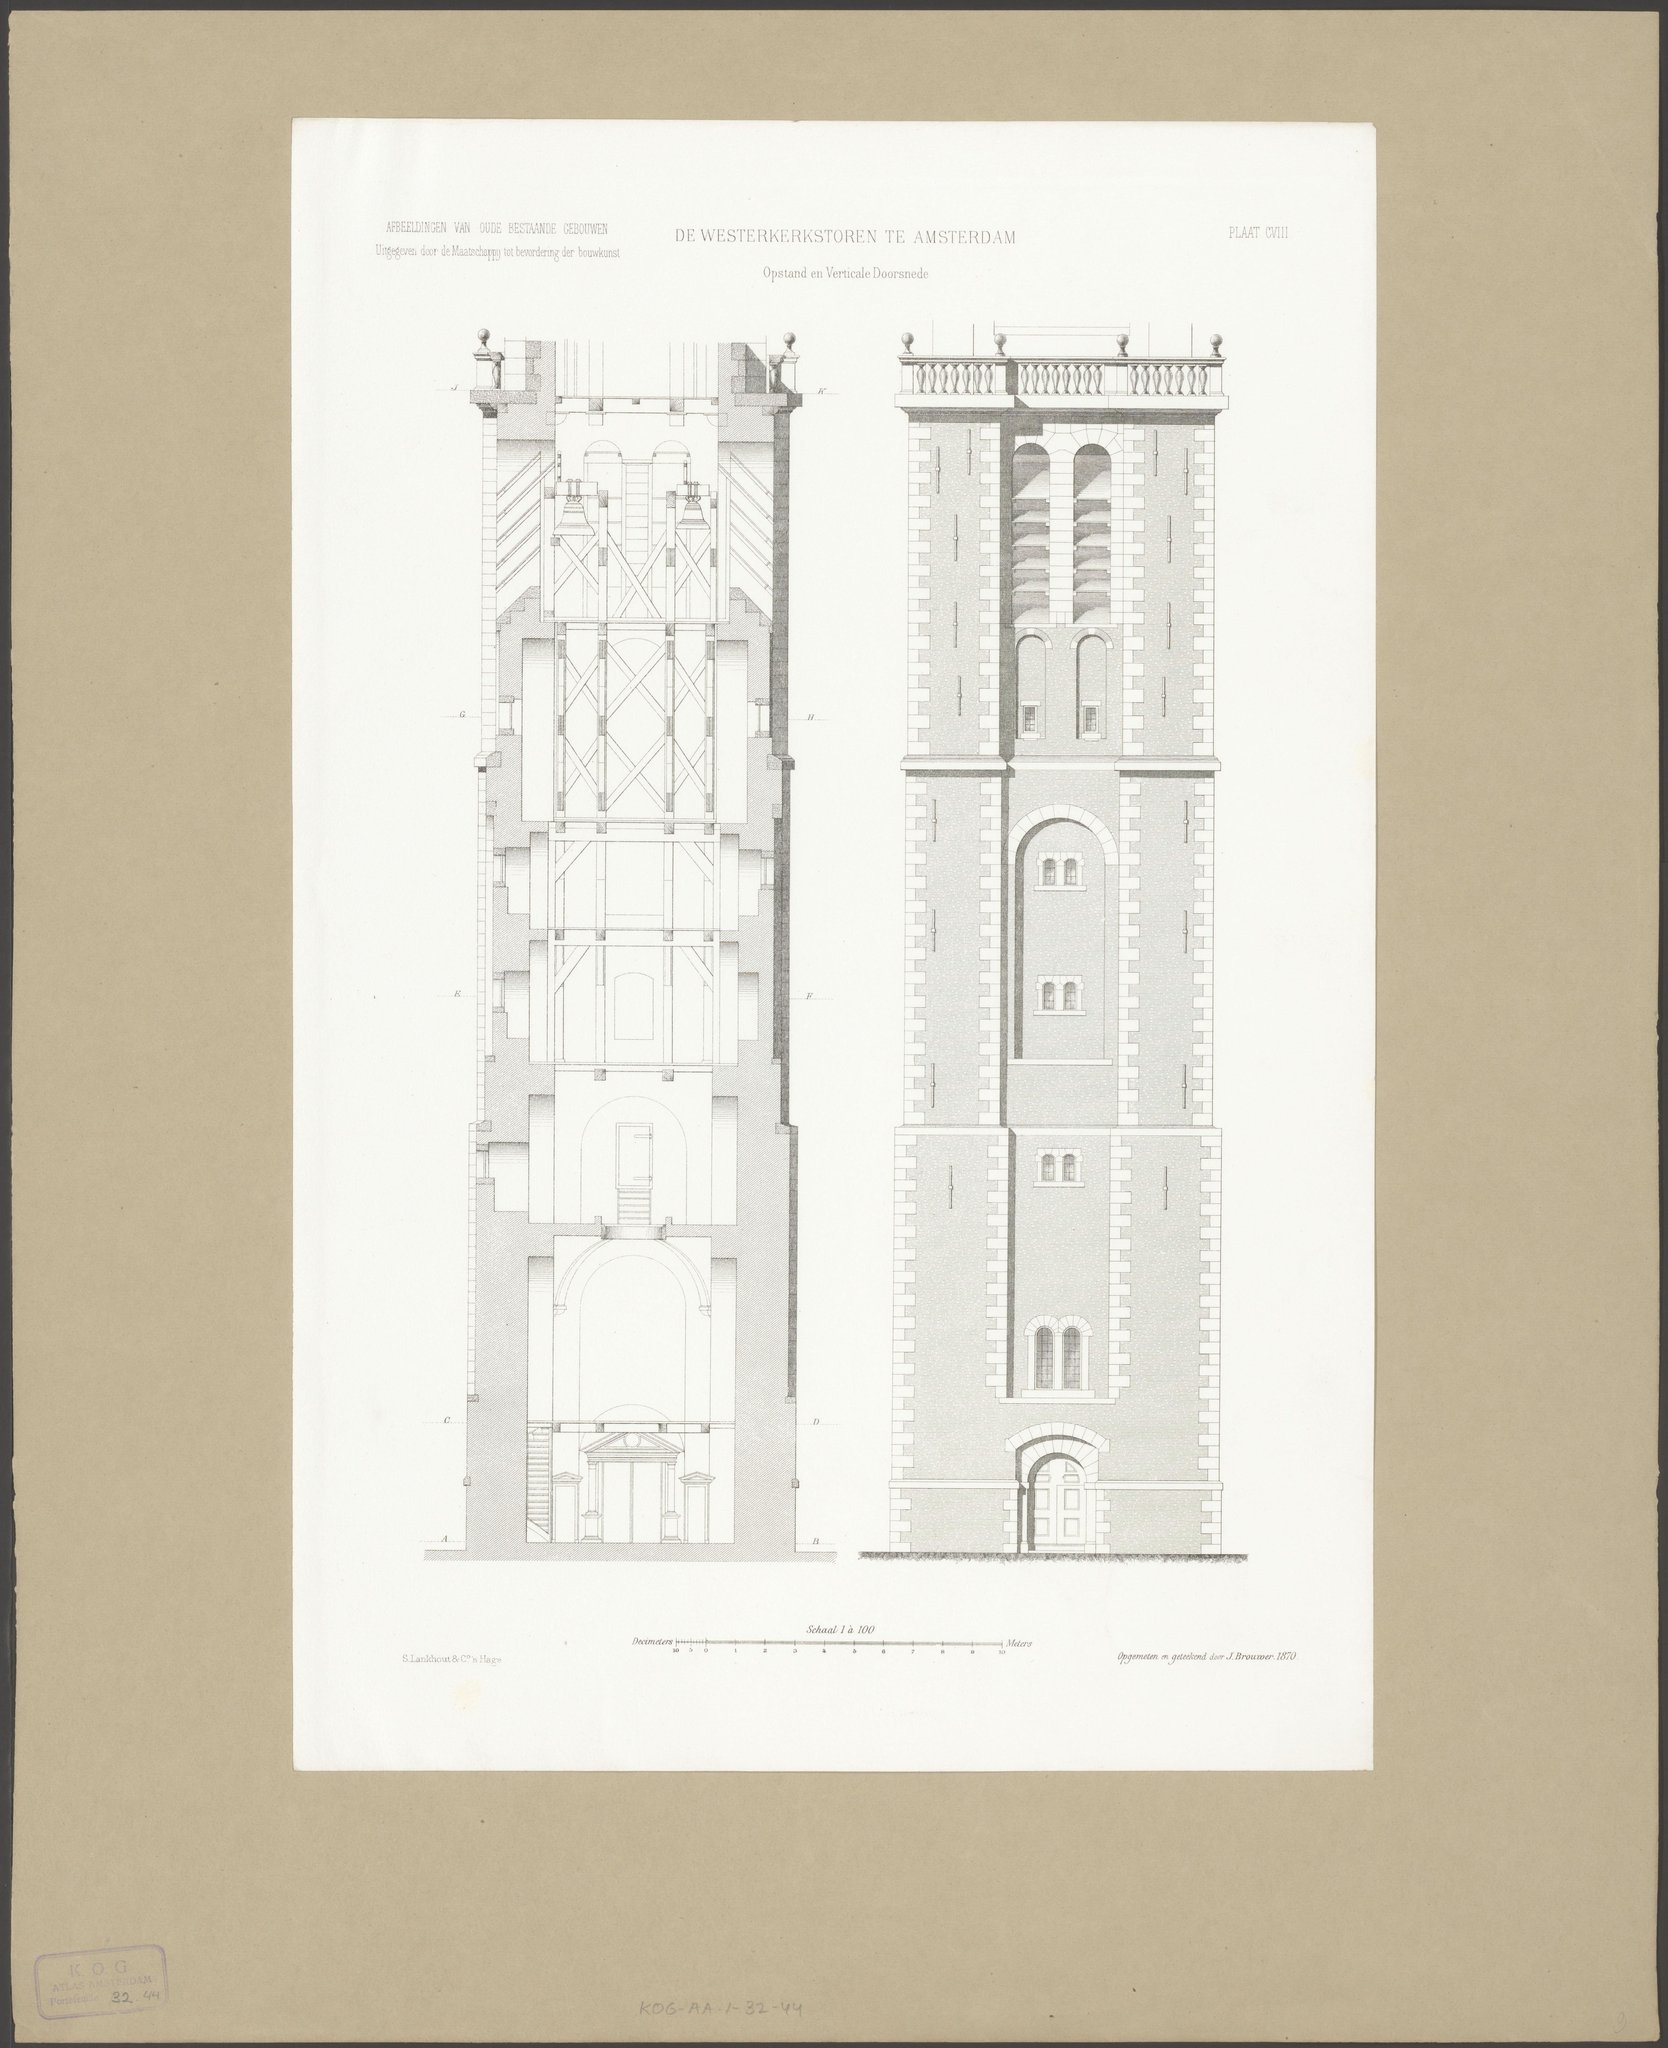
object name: photomechanical print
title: Afbeeldingen van oude bestaande gebouwen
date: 1870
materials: paper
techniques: photolithography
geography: amsterdam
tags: plan ~ architecture, parts of church exterior and annexes: tower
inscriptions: collector's mark: ‘32.44’ Lugt 1641b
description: Rechtsboven genummerd: CVIII. Onderaan een schaalroede. Onderwerpsrubriek binnen de Atlas Amsterdam: Kerkwezen: Hervormde Gemeente: Westerkerk.